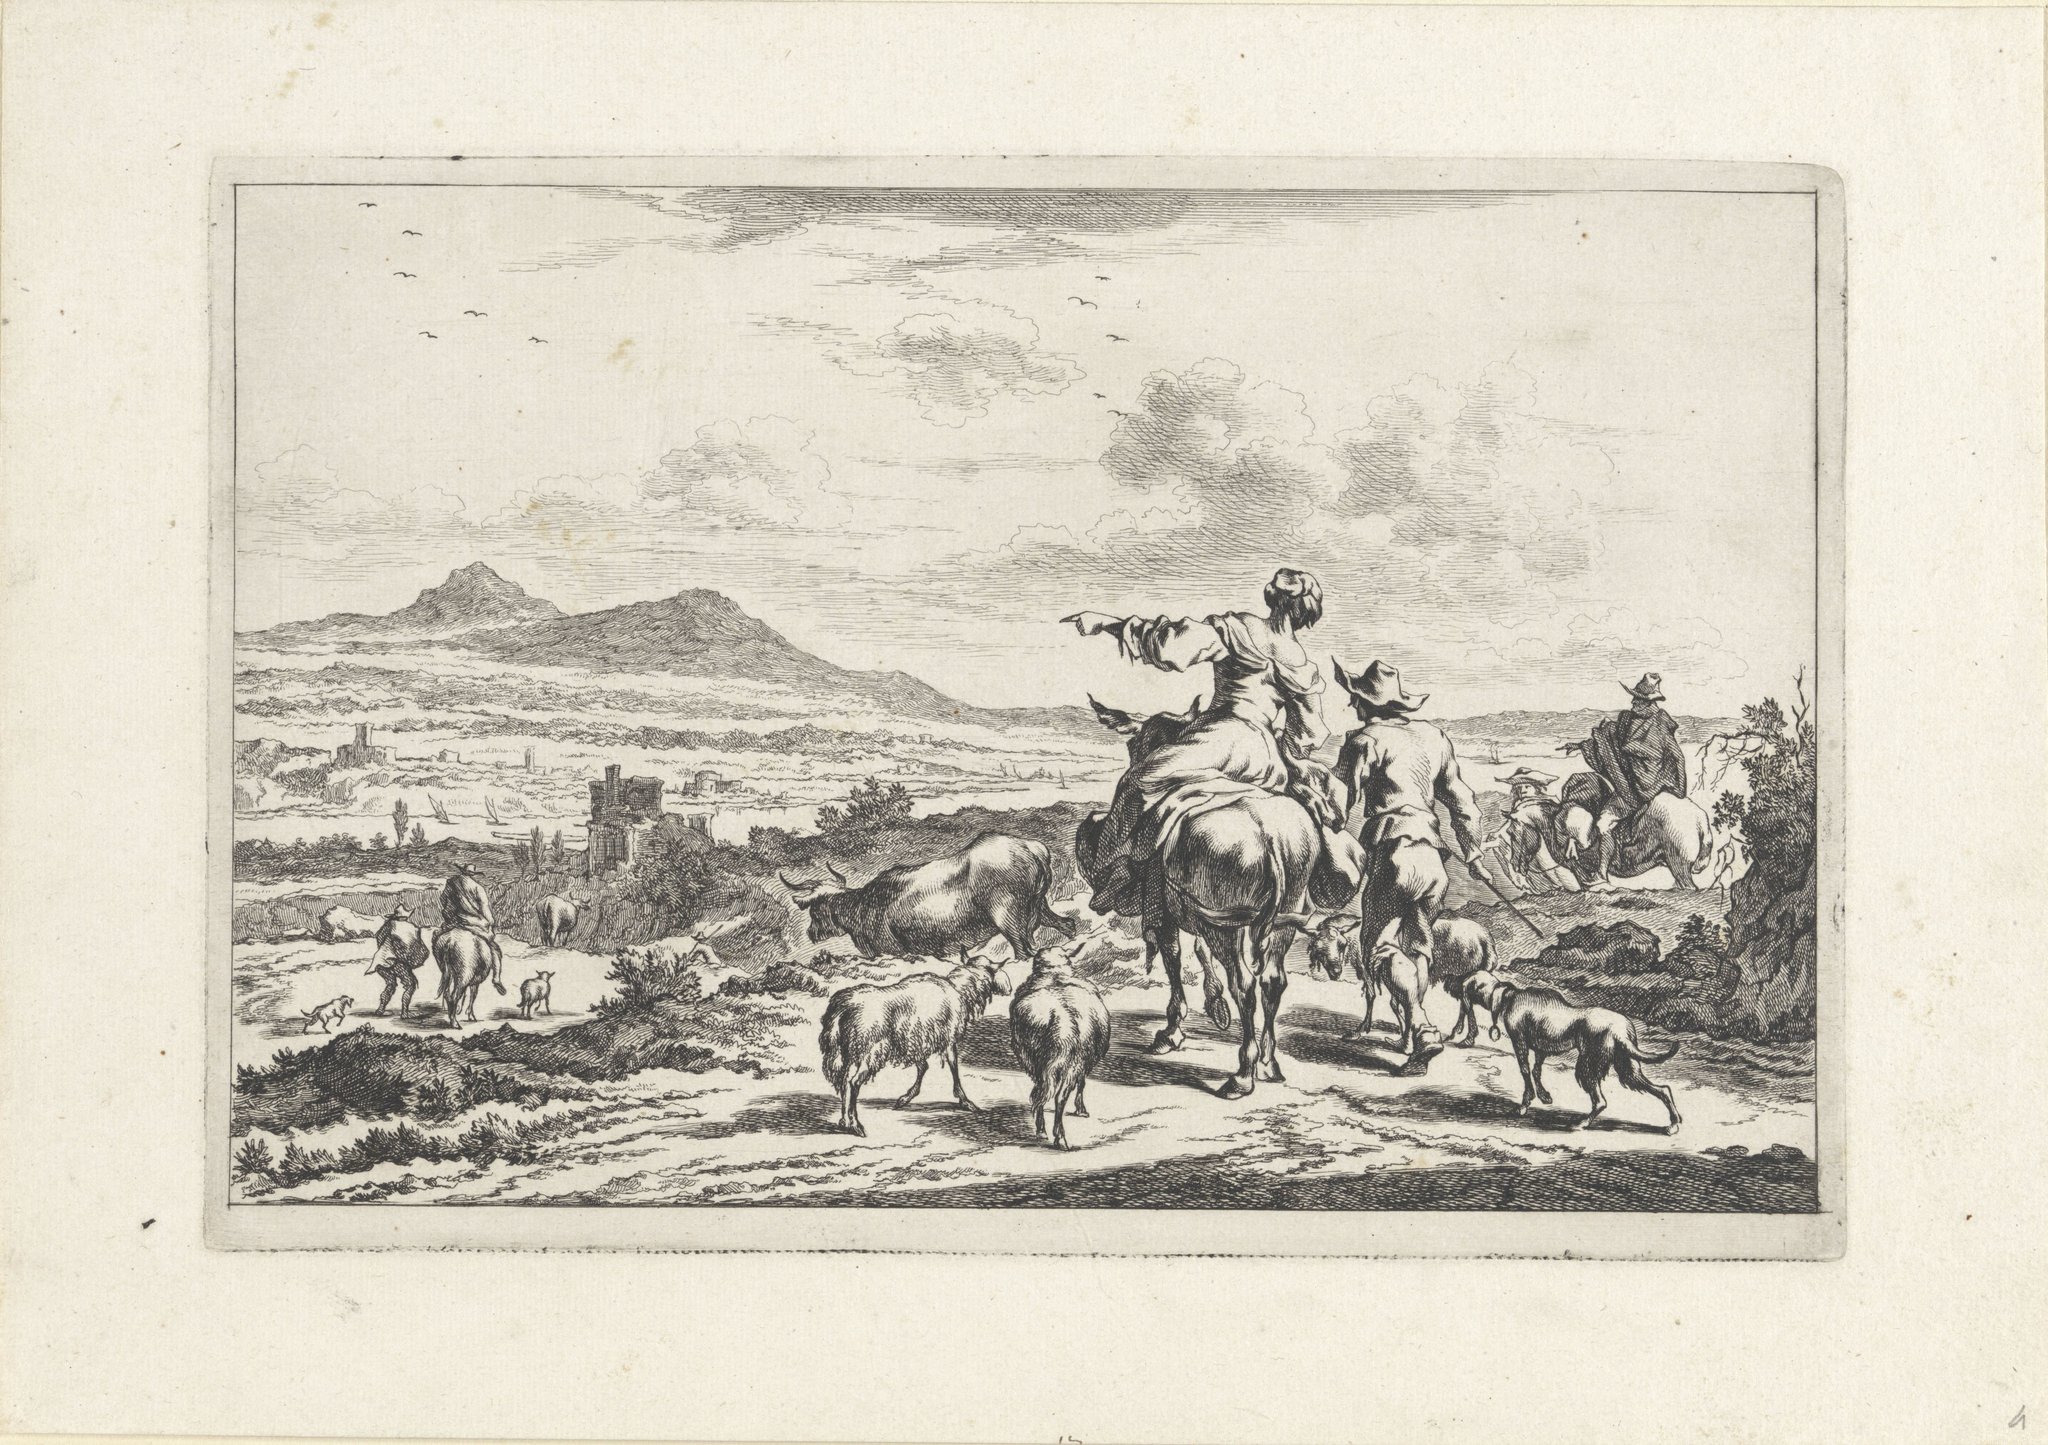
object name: print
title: Herders naderen een dorp in een dal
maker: jan de visscher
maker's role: print maker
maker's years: 1633-1712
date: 1643-1692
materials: paper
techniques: engraving, etching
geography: northern netherlands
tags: cow, landscapes, ass, donkey, herding, herdsman, herdswoman, shepherd, shepherdess, cowherd, etc., village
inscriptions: collector's mark: Lugt 240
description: Gezicht op een heuvelachtig landschap met op de voorgrond een groep herders waarvan er twee naar een dorp in een dal wijzen.